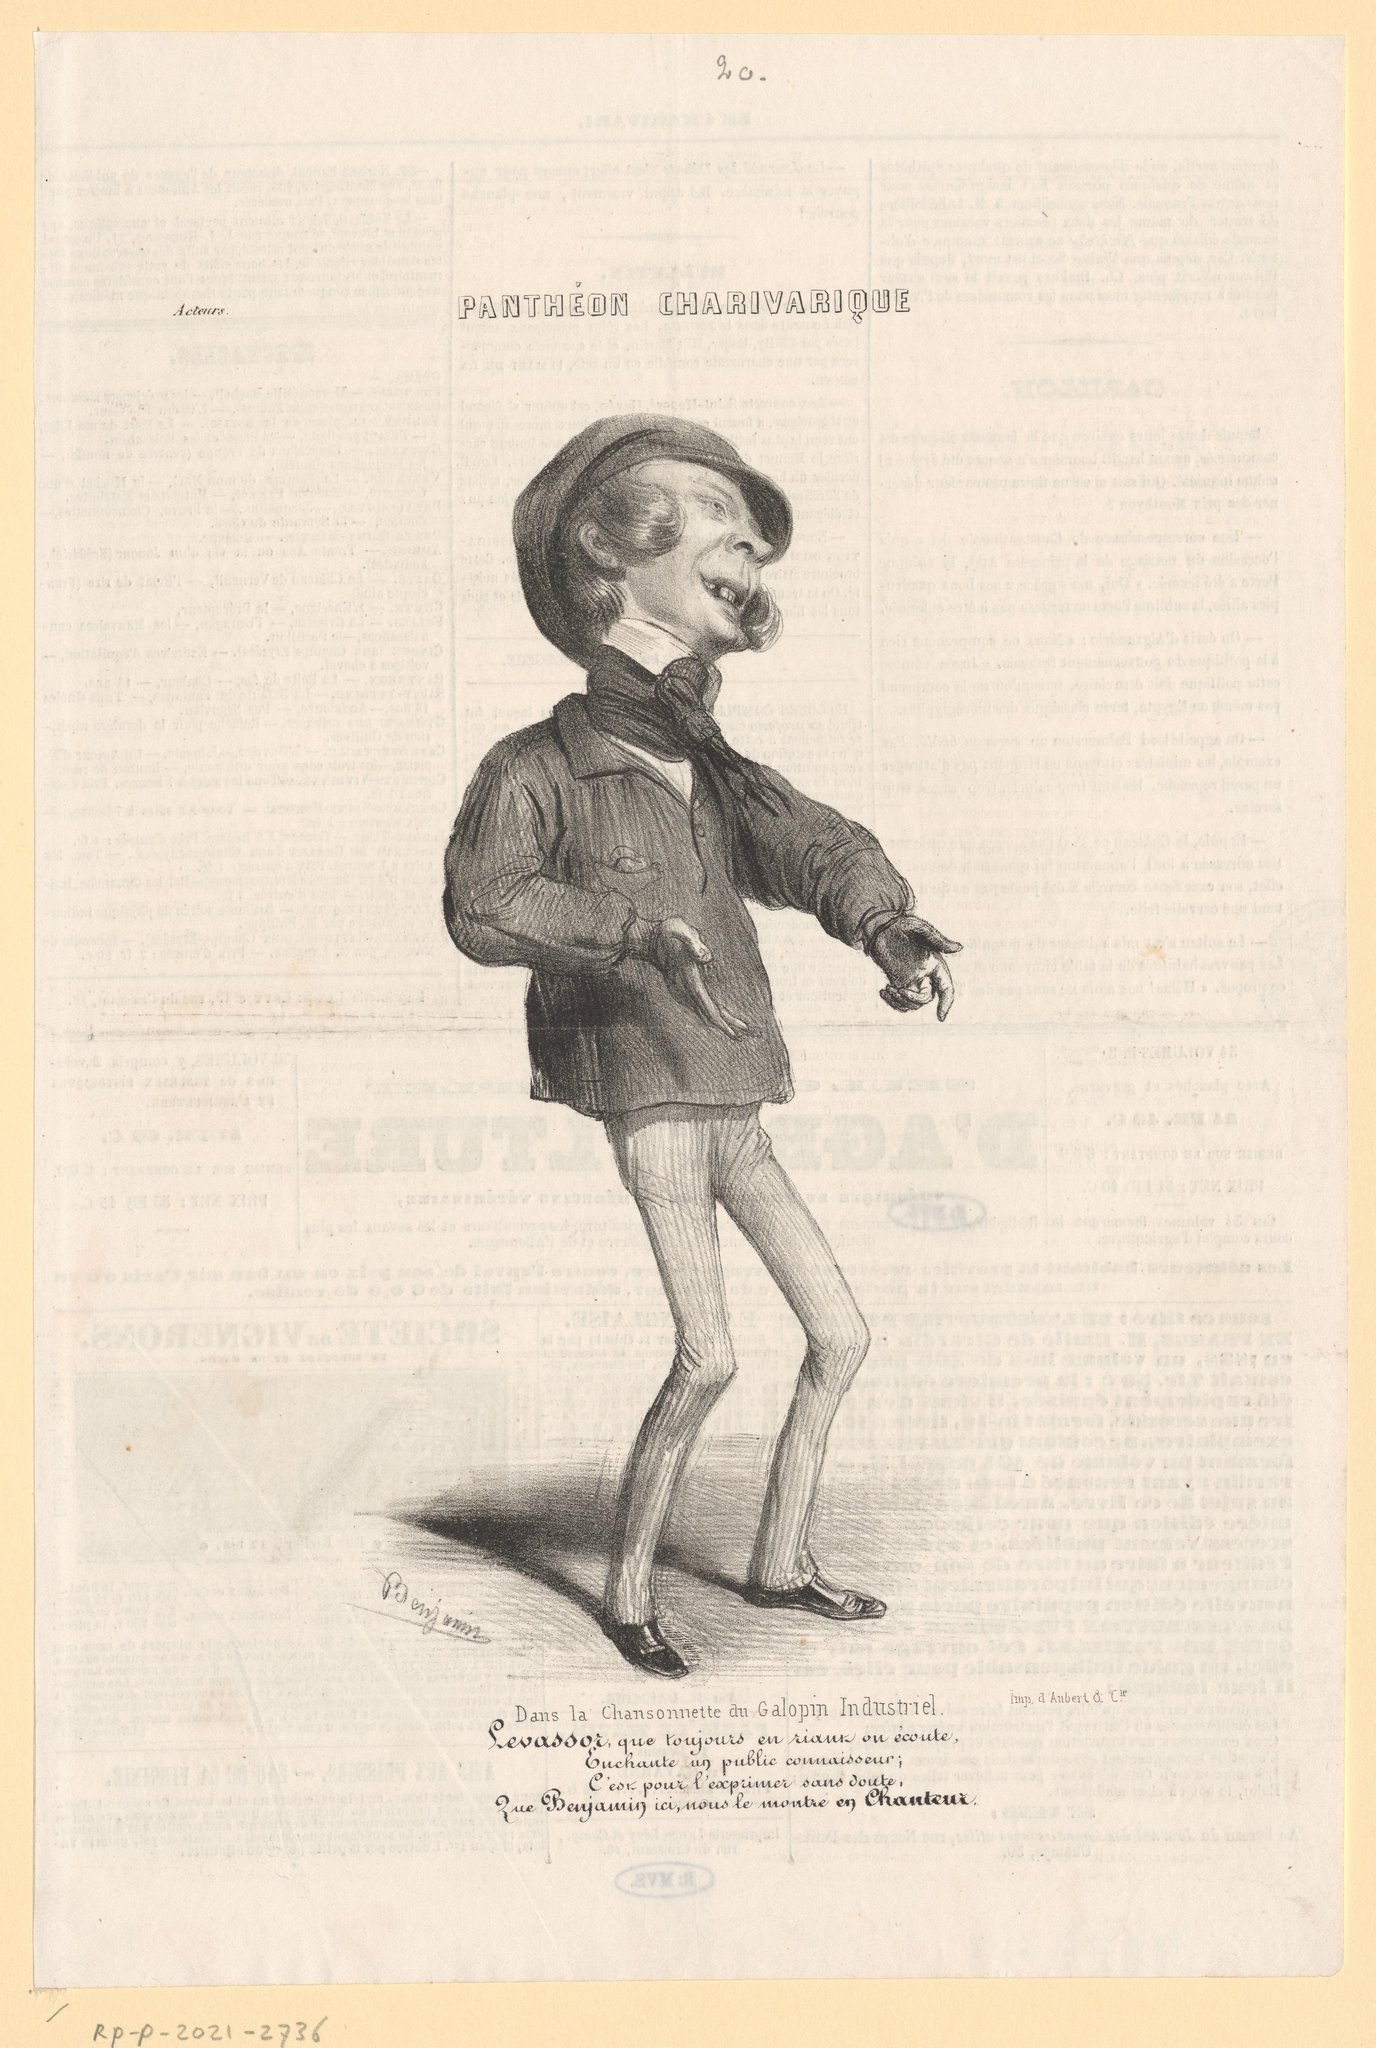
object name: cartoon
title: Panthéon Charivarique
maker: benjamin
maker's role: print maker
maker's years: 1811-1847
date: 1838-1845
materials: paper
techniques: letterpress printing, lithograph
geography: paris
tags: caricatures (human types), historical persons, portrait of opera-singer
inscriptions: collector's mark: ‘[R?]oyal Tim[...]’, collector's mark: Lugt 2228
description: Uit de serie: Panthéon charivarique, bestaande uit 100 portretten van tekenaars, schrijvers, schilders, beeldhouwers, musici en acteurs. Prent uit een editie van Le Charivari.